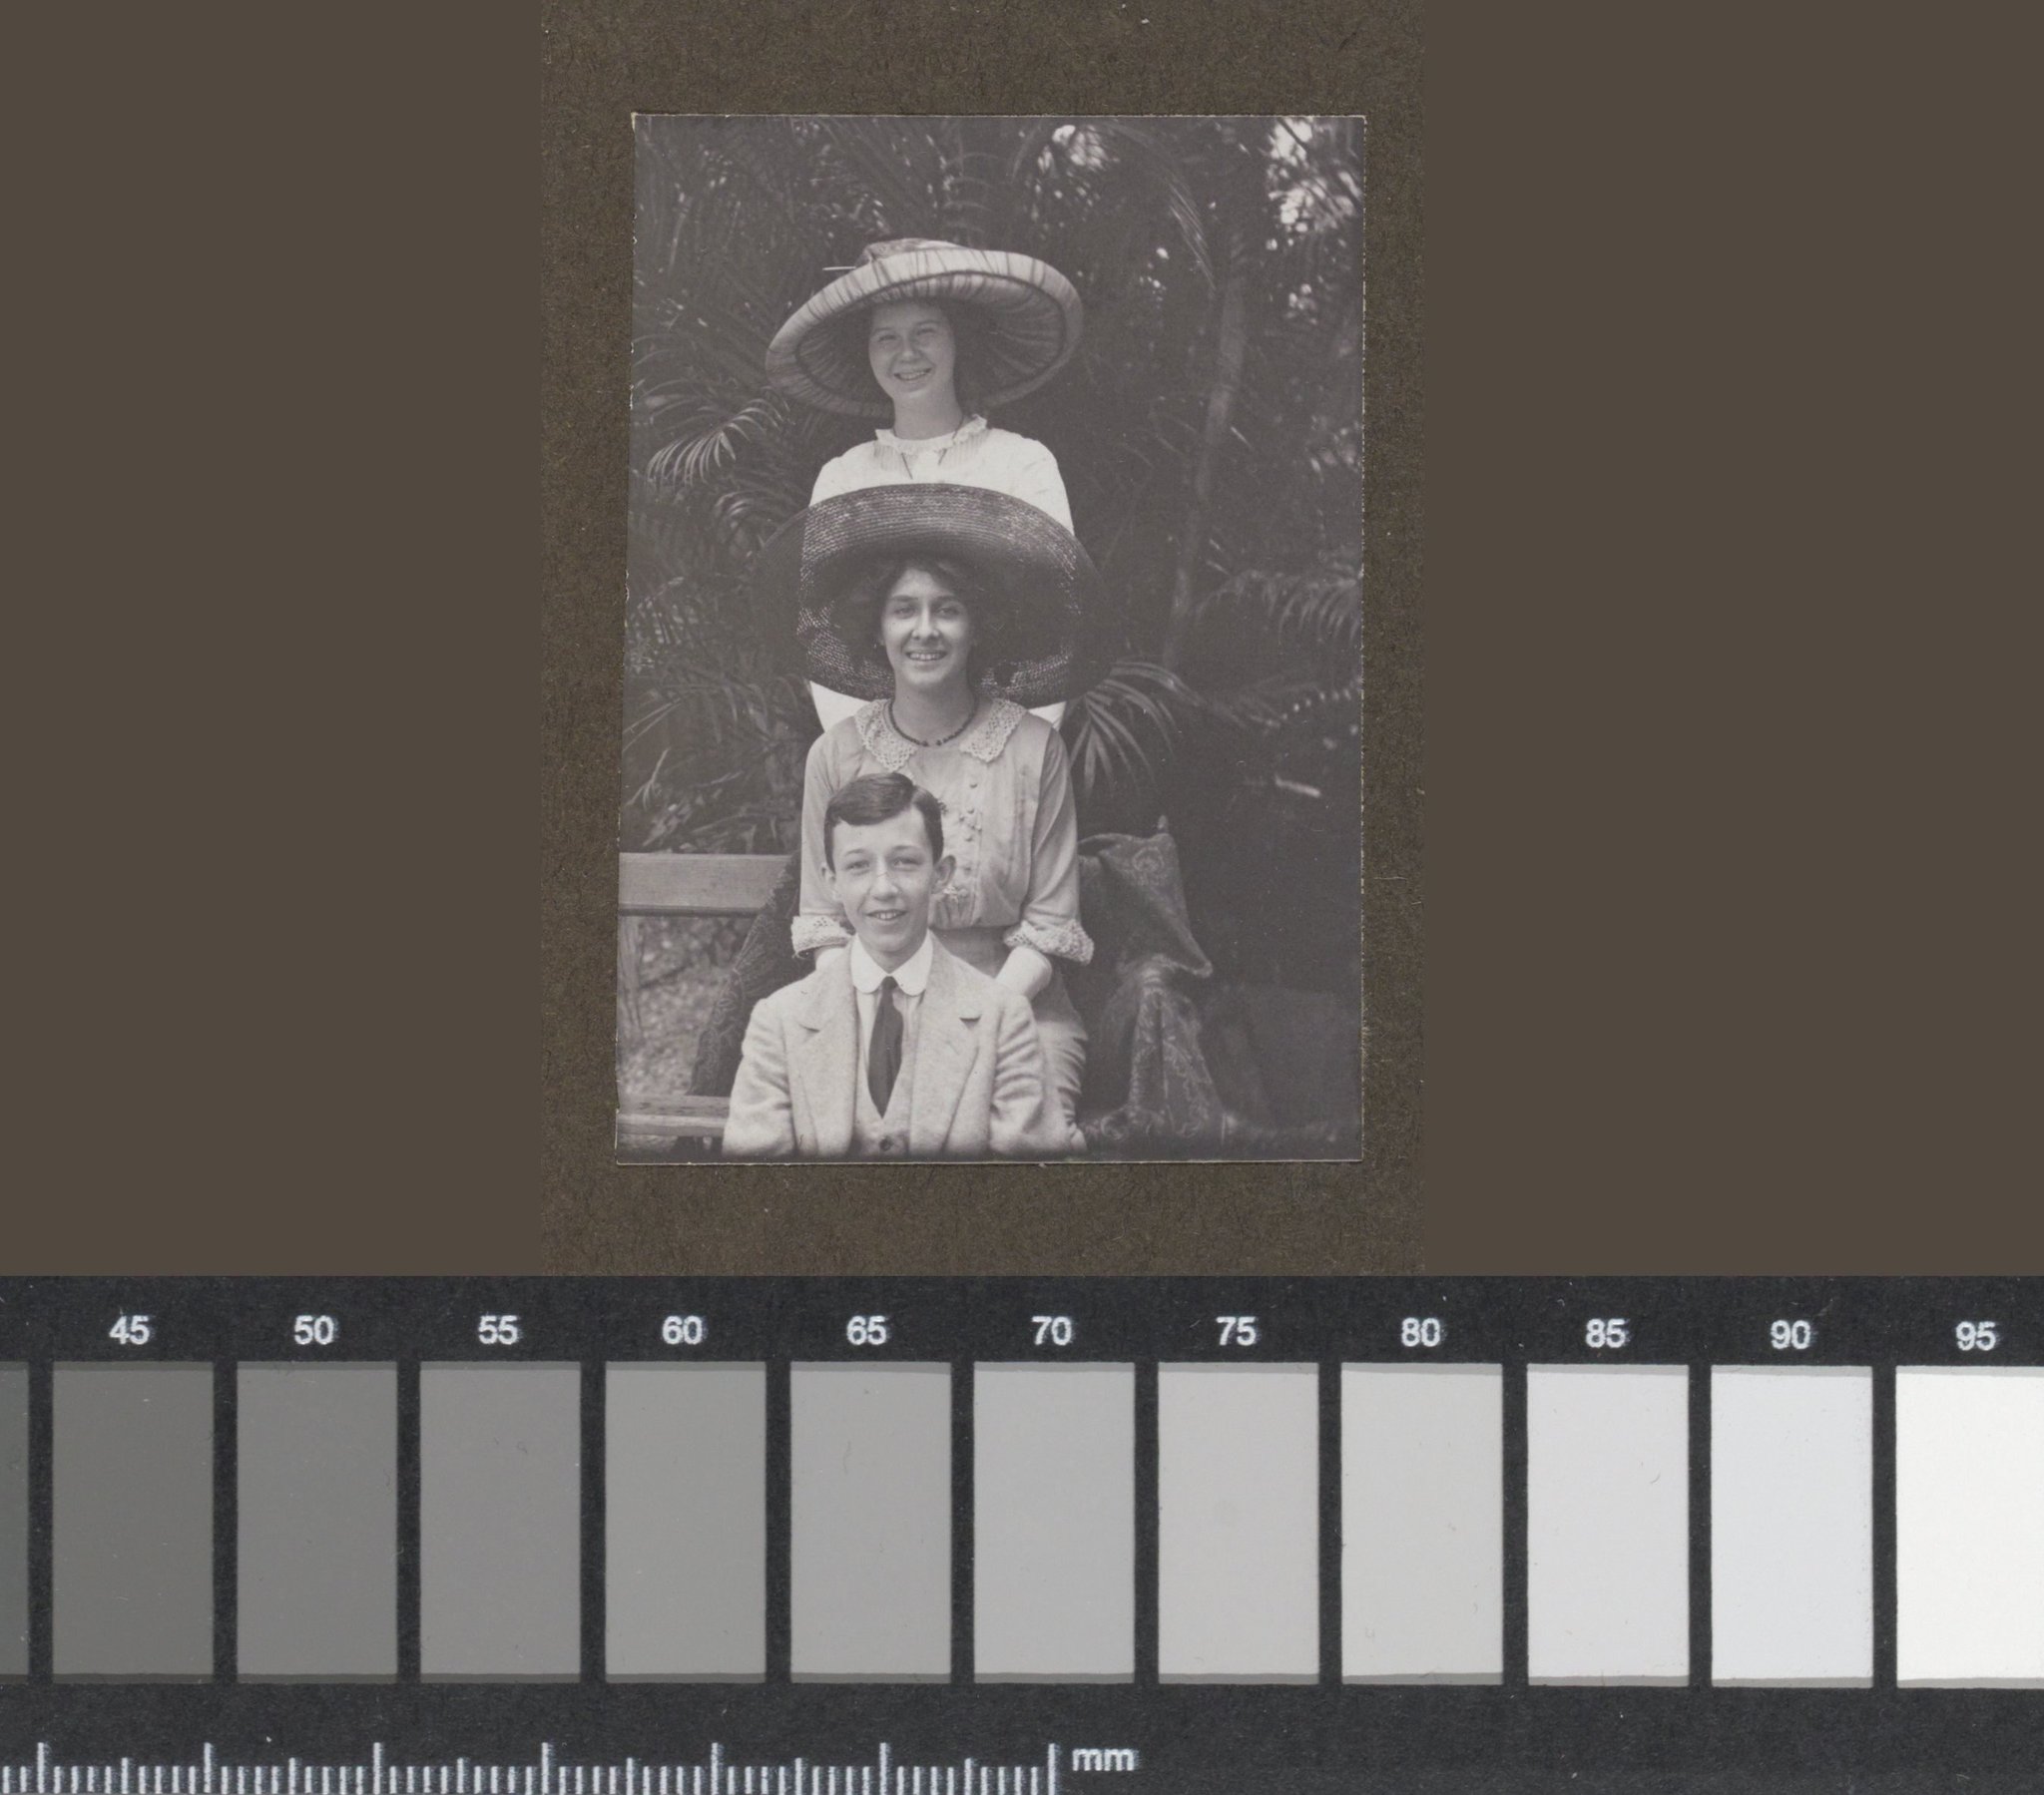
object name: photograph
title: Maria Gonggrijp met een jongen en een jonge vrouw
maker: Anonymous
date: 1910-1914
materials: photographic support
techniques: photography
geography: suriname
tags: suriname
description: Maria Gonggrijp poserend met een jongen en een vriendin. De beide vrouwen dragen een grote zonnehoed. Onderdeel van een groep van elf albumbladen met familiefoto's van de familie Gonggrijp in Suriname, ca. 1912.